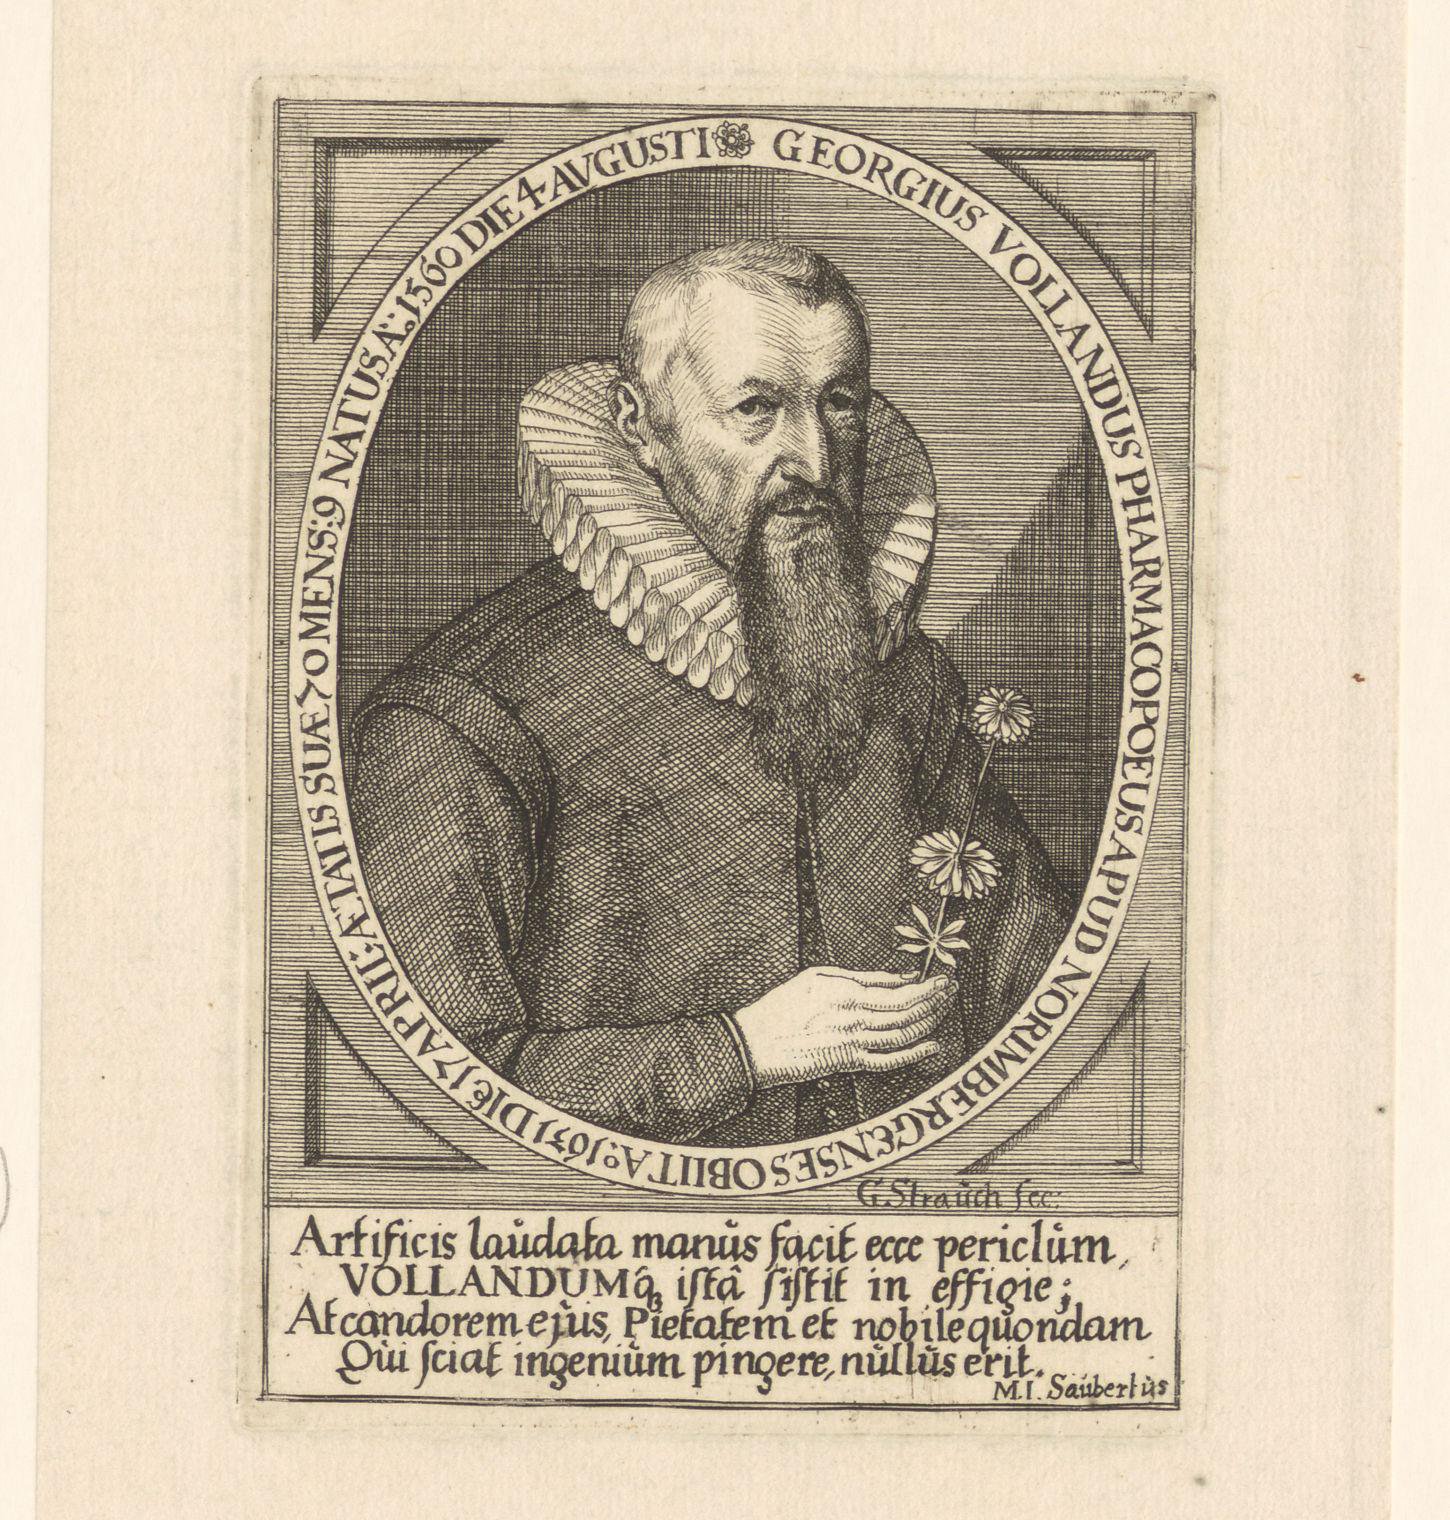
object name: print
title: Portret van Georg Volland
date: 1631-1675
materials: paper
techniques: etching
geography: nuremberg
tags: flowers, historical persons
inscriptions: collector's mark: Lugt 2228